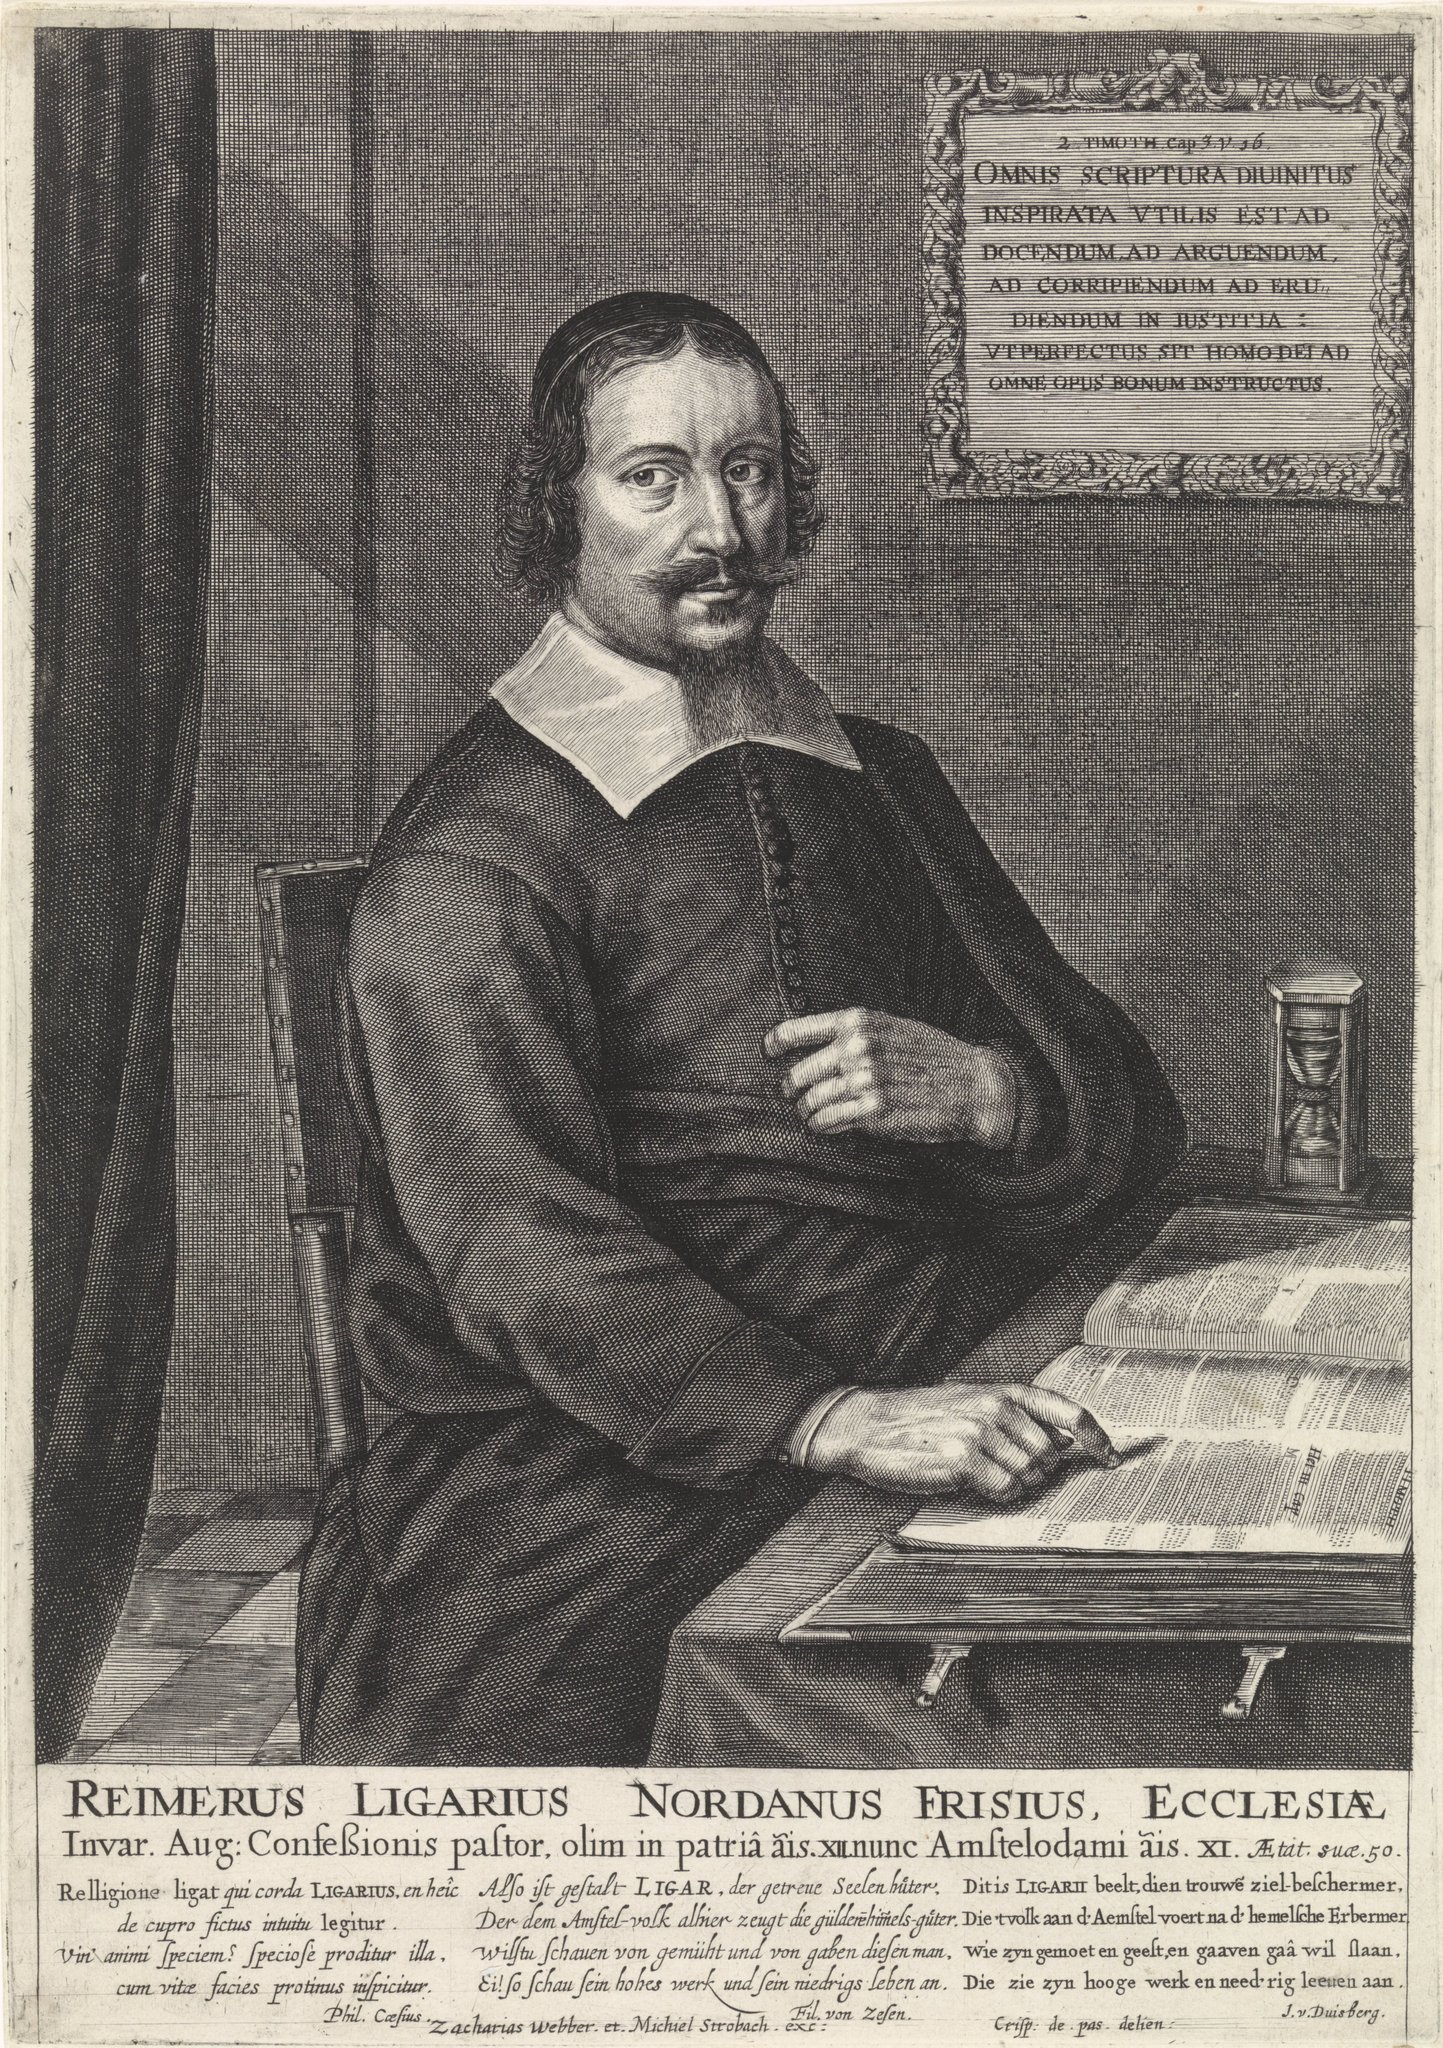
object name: print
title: Portret van Reimerus Ligarius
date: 1644-1646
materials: paper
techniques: engraving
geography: amsterdam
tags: reading the bible or other religious books, hourglass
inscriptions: collector's mark: Lugt 2228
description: Portret van Reimerus Ligarius, Luthers predikant te Amsterdam, op 50-jarige leeftijd. Op zijn schrijftafel ligt een opengeslagen bijbel en staat een zandloper. Rechtsboven een Bijbelcitaat uit 2 Tim. 3:16, in het Latijn. In de marge een vierregelig lofdicht in het Latijn, in het Duits en in het Nederlands.